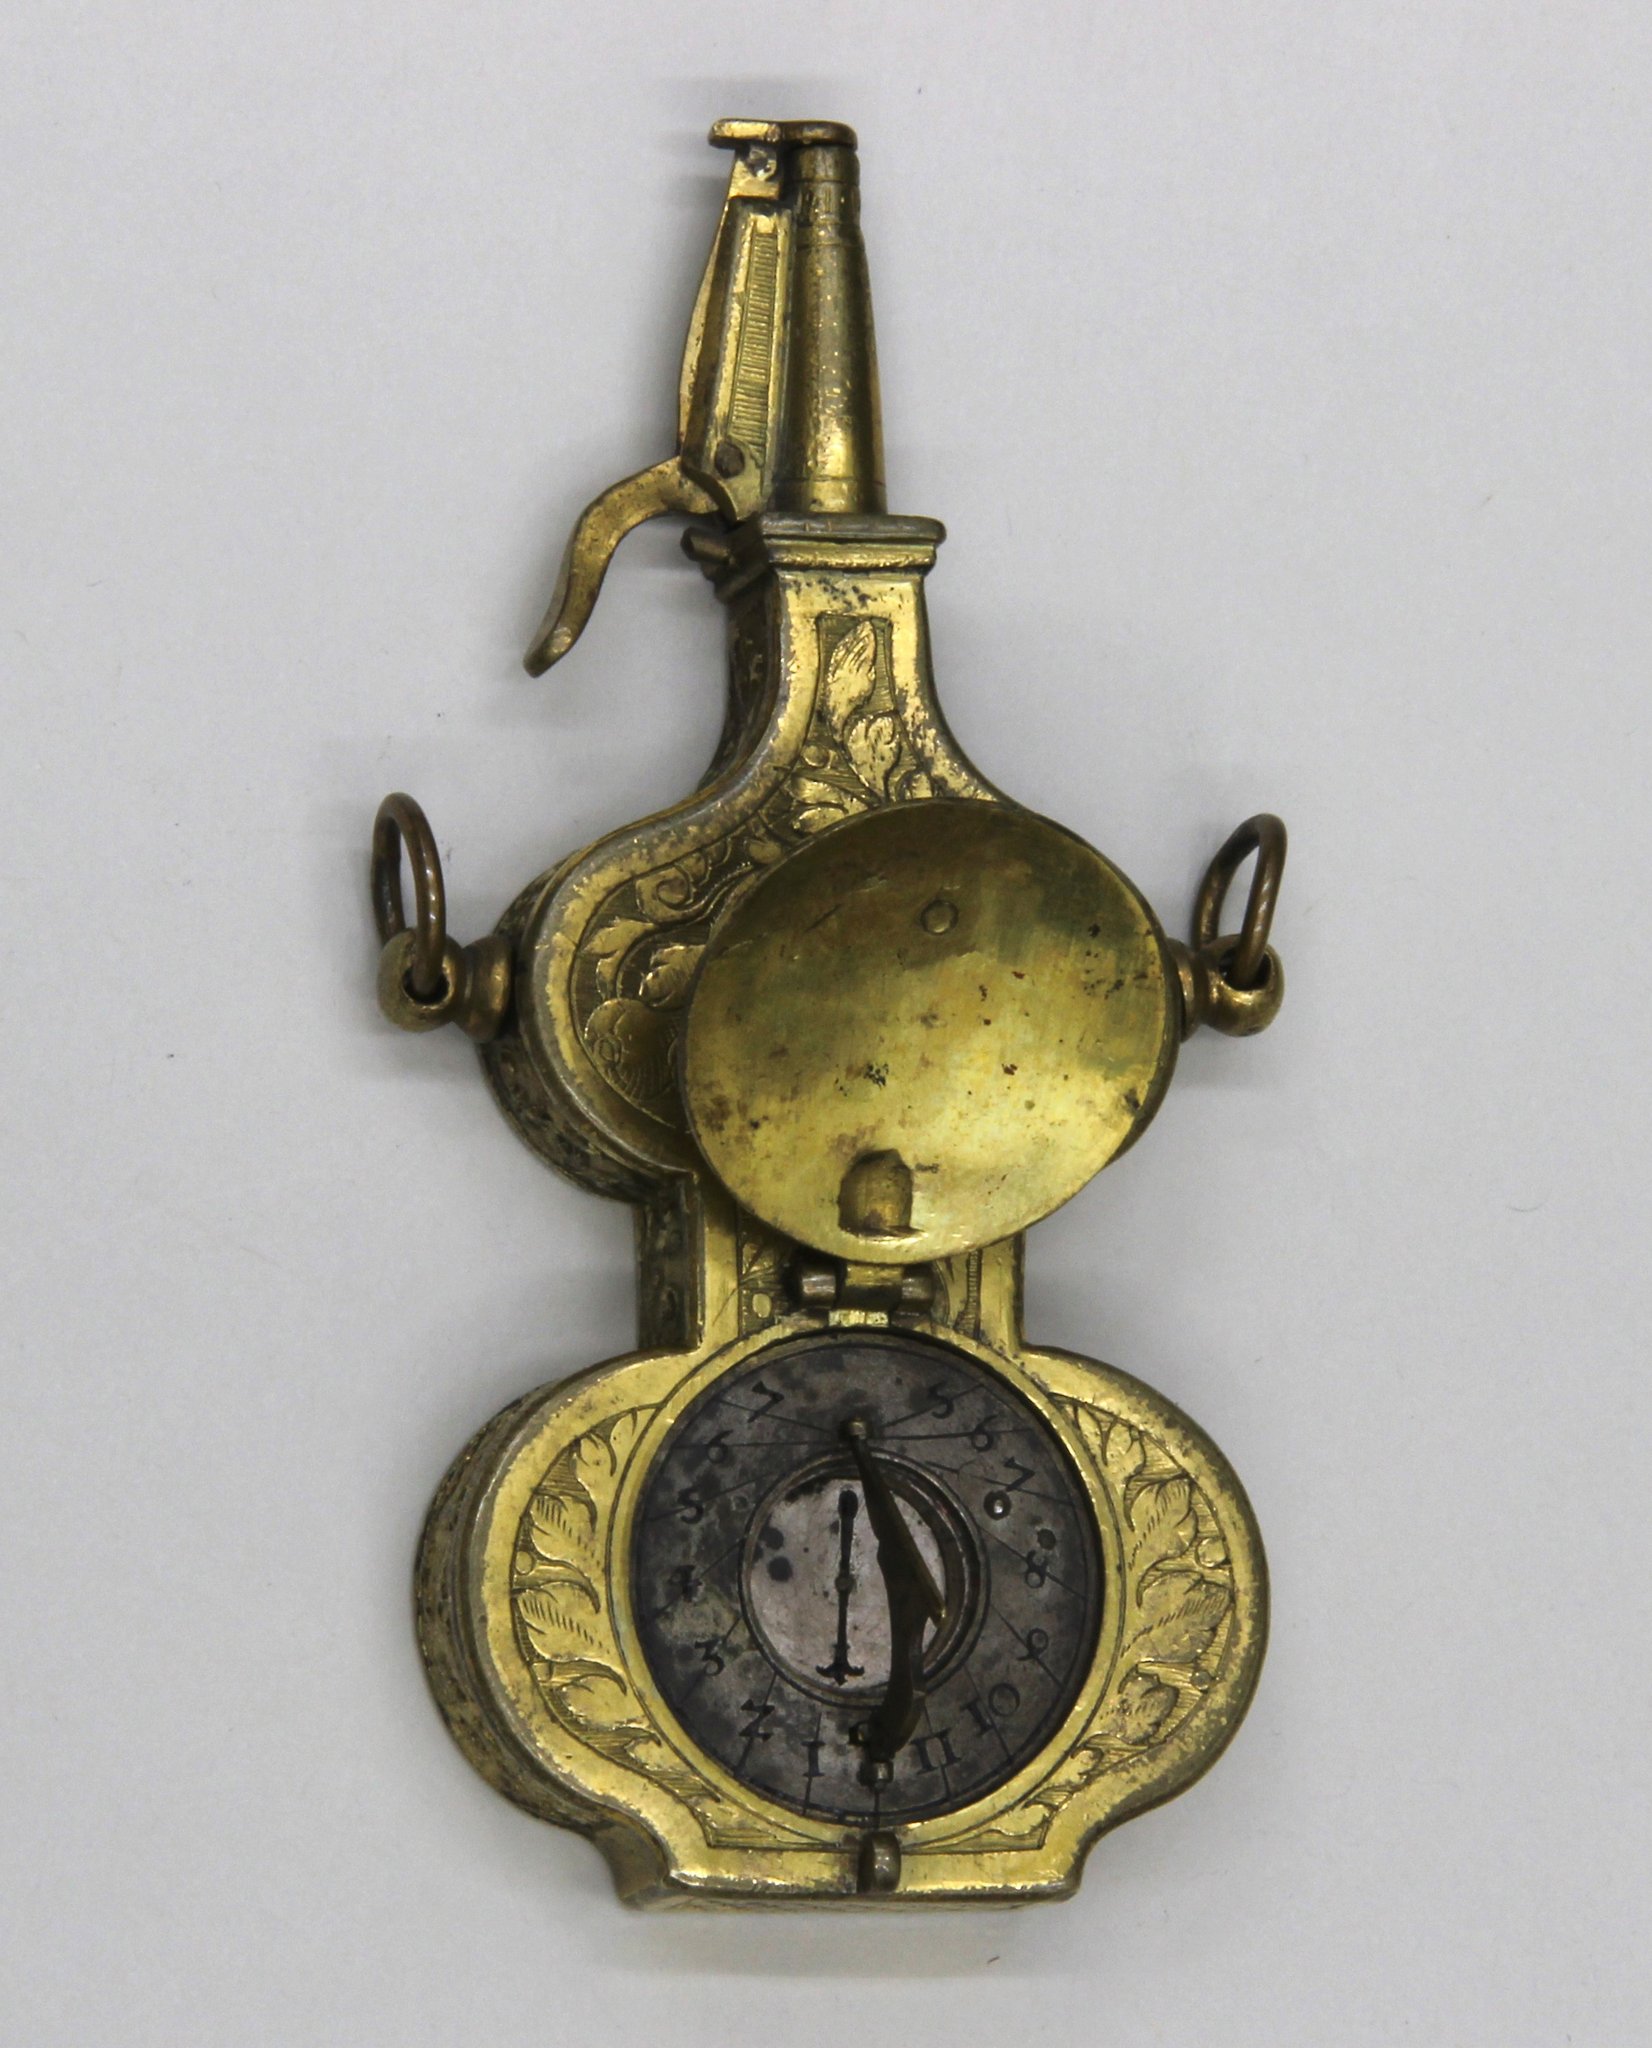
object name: priming flask with sundial and compass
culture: german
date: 1567-1600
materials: brass, gold, silver, steel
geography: germany